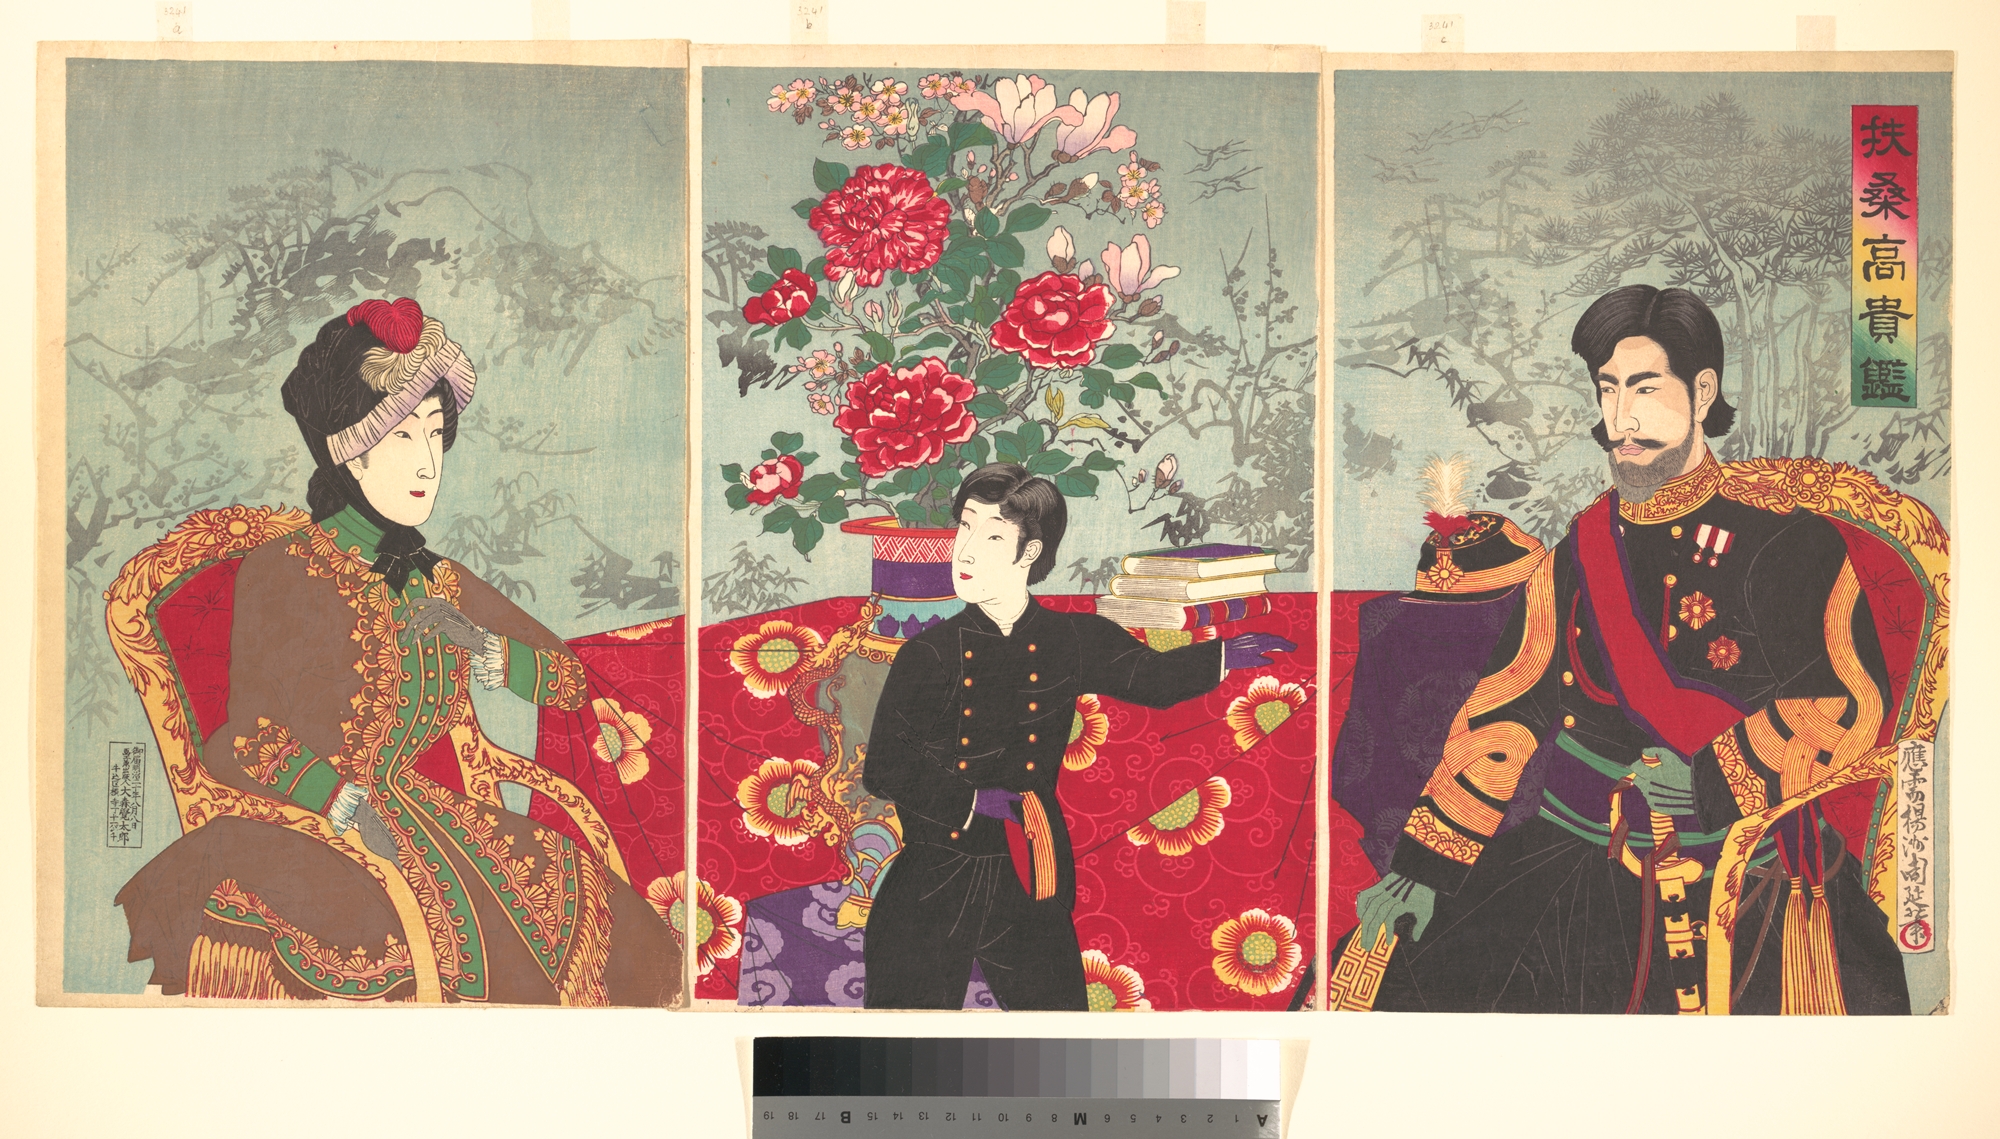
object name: print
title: A Mirror of Japan’s Nobility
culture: japanese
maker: yōshū (hashimoto) chikanobu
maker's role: artist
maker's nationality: japanese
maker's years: 1838-1912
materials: ink, paper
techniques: nishiki e, woodblock print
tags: kings,princes,queens,flowers